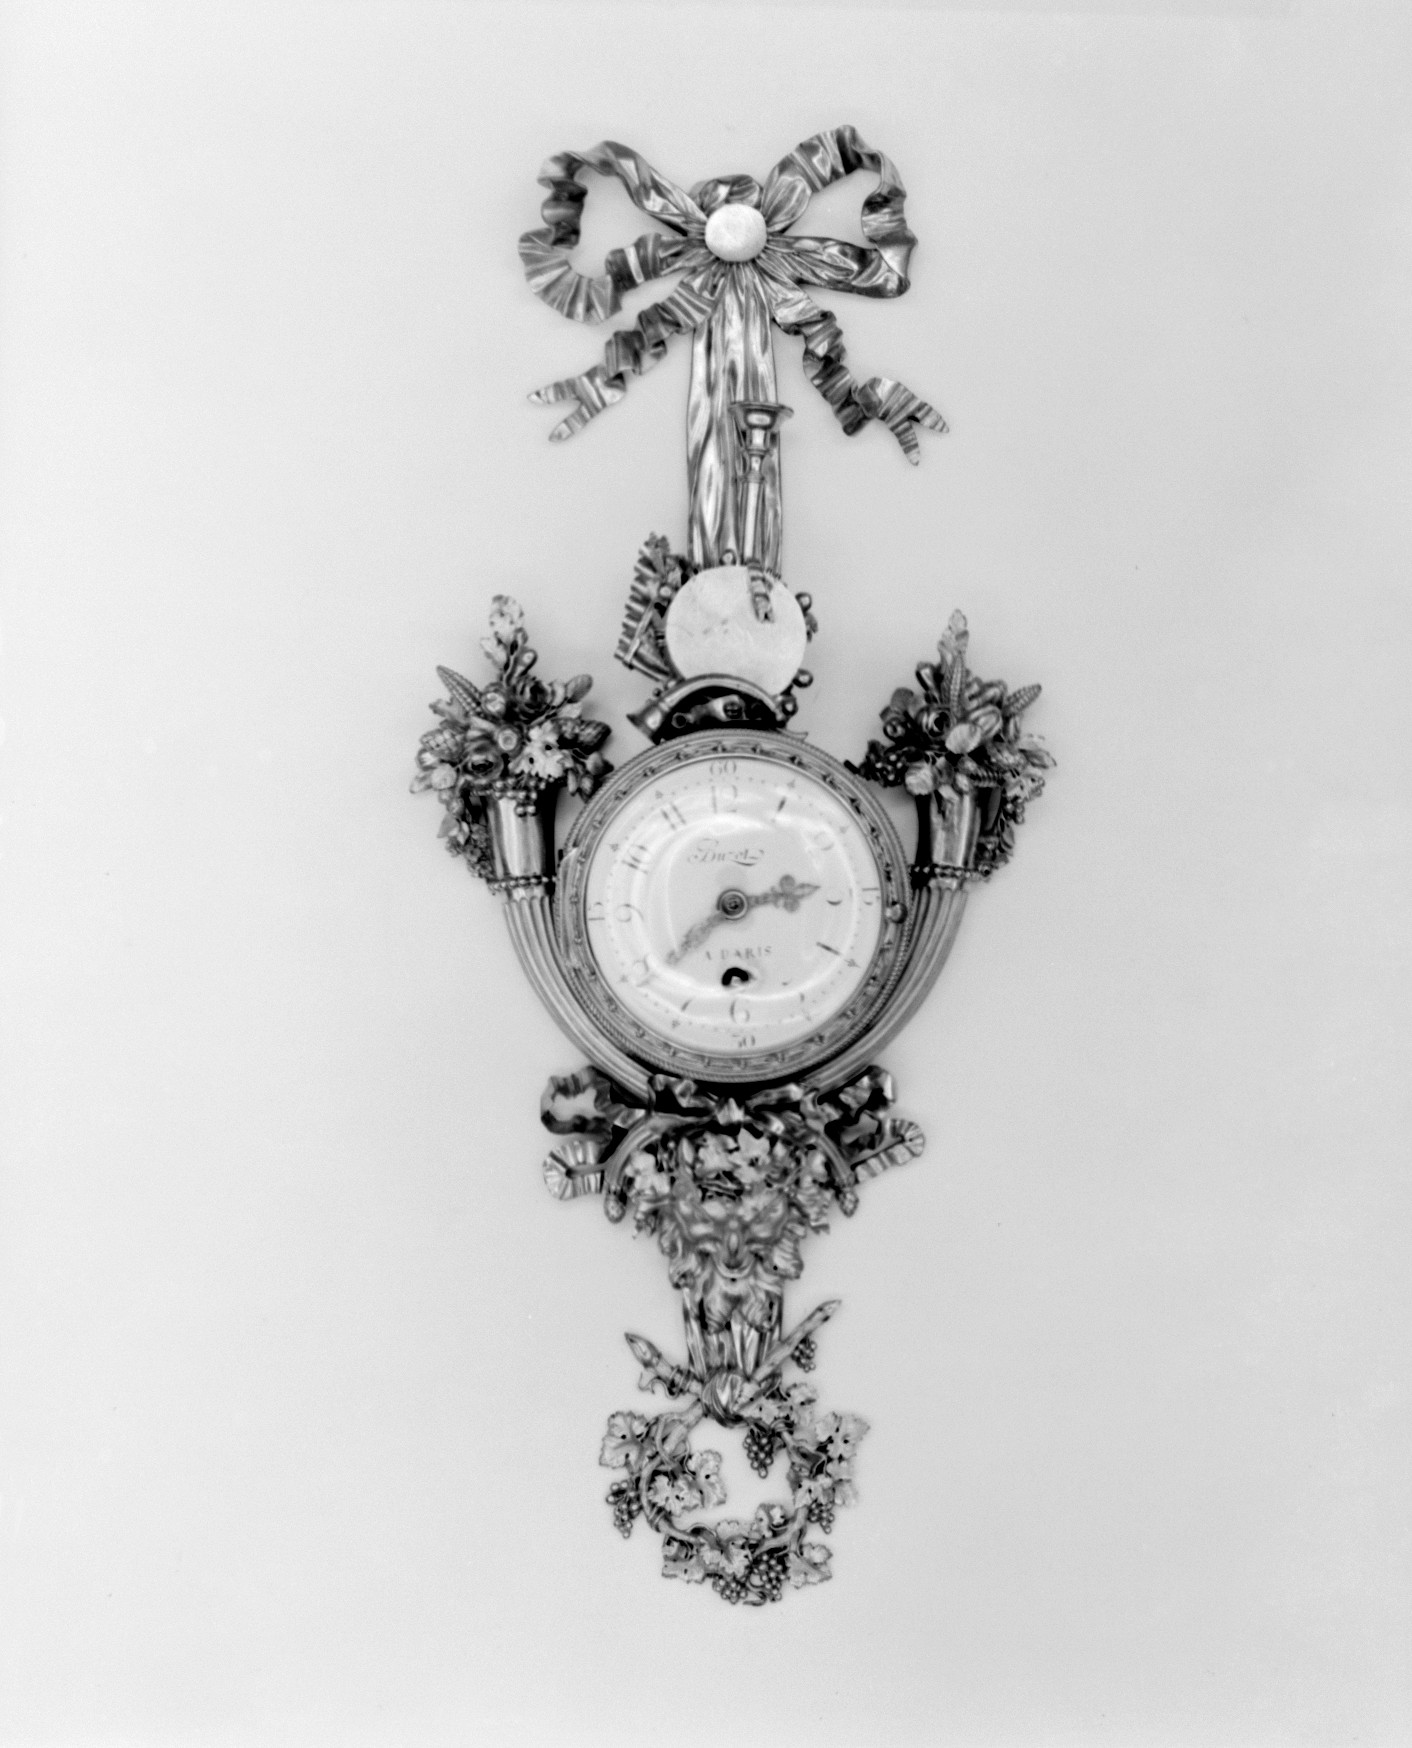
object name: wall clock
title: Wall clock (pendule en cartel)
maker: joseph buzot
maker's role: maker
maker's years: 1770-1789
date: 1785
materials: gilt bronze, glass, metal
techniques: enamel